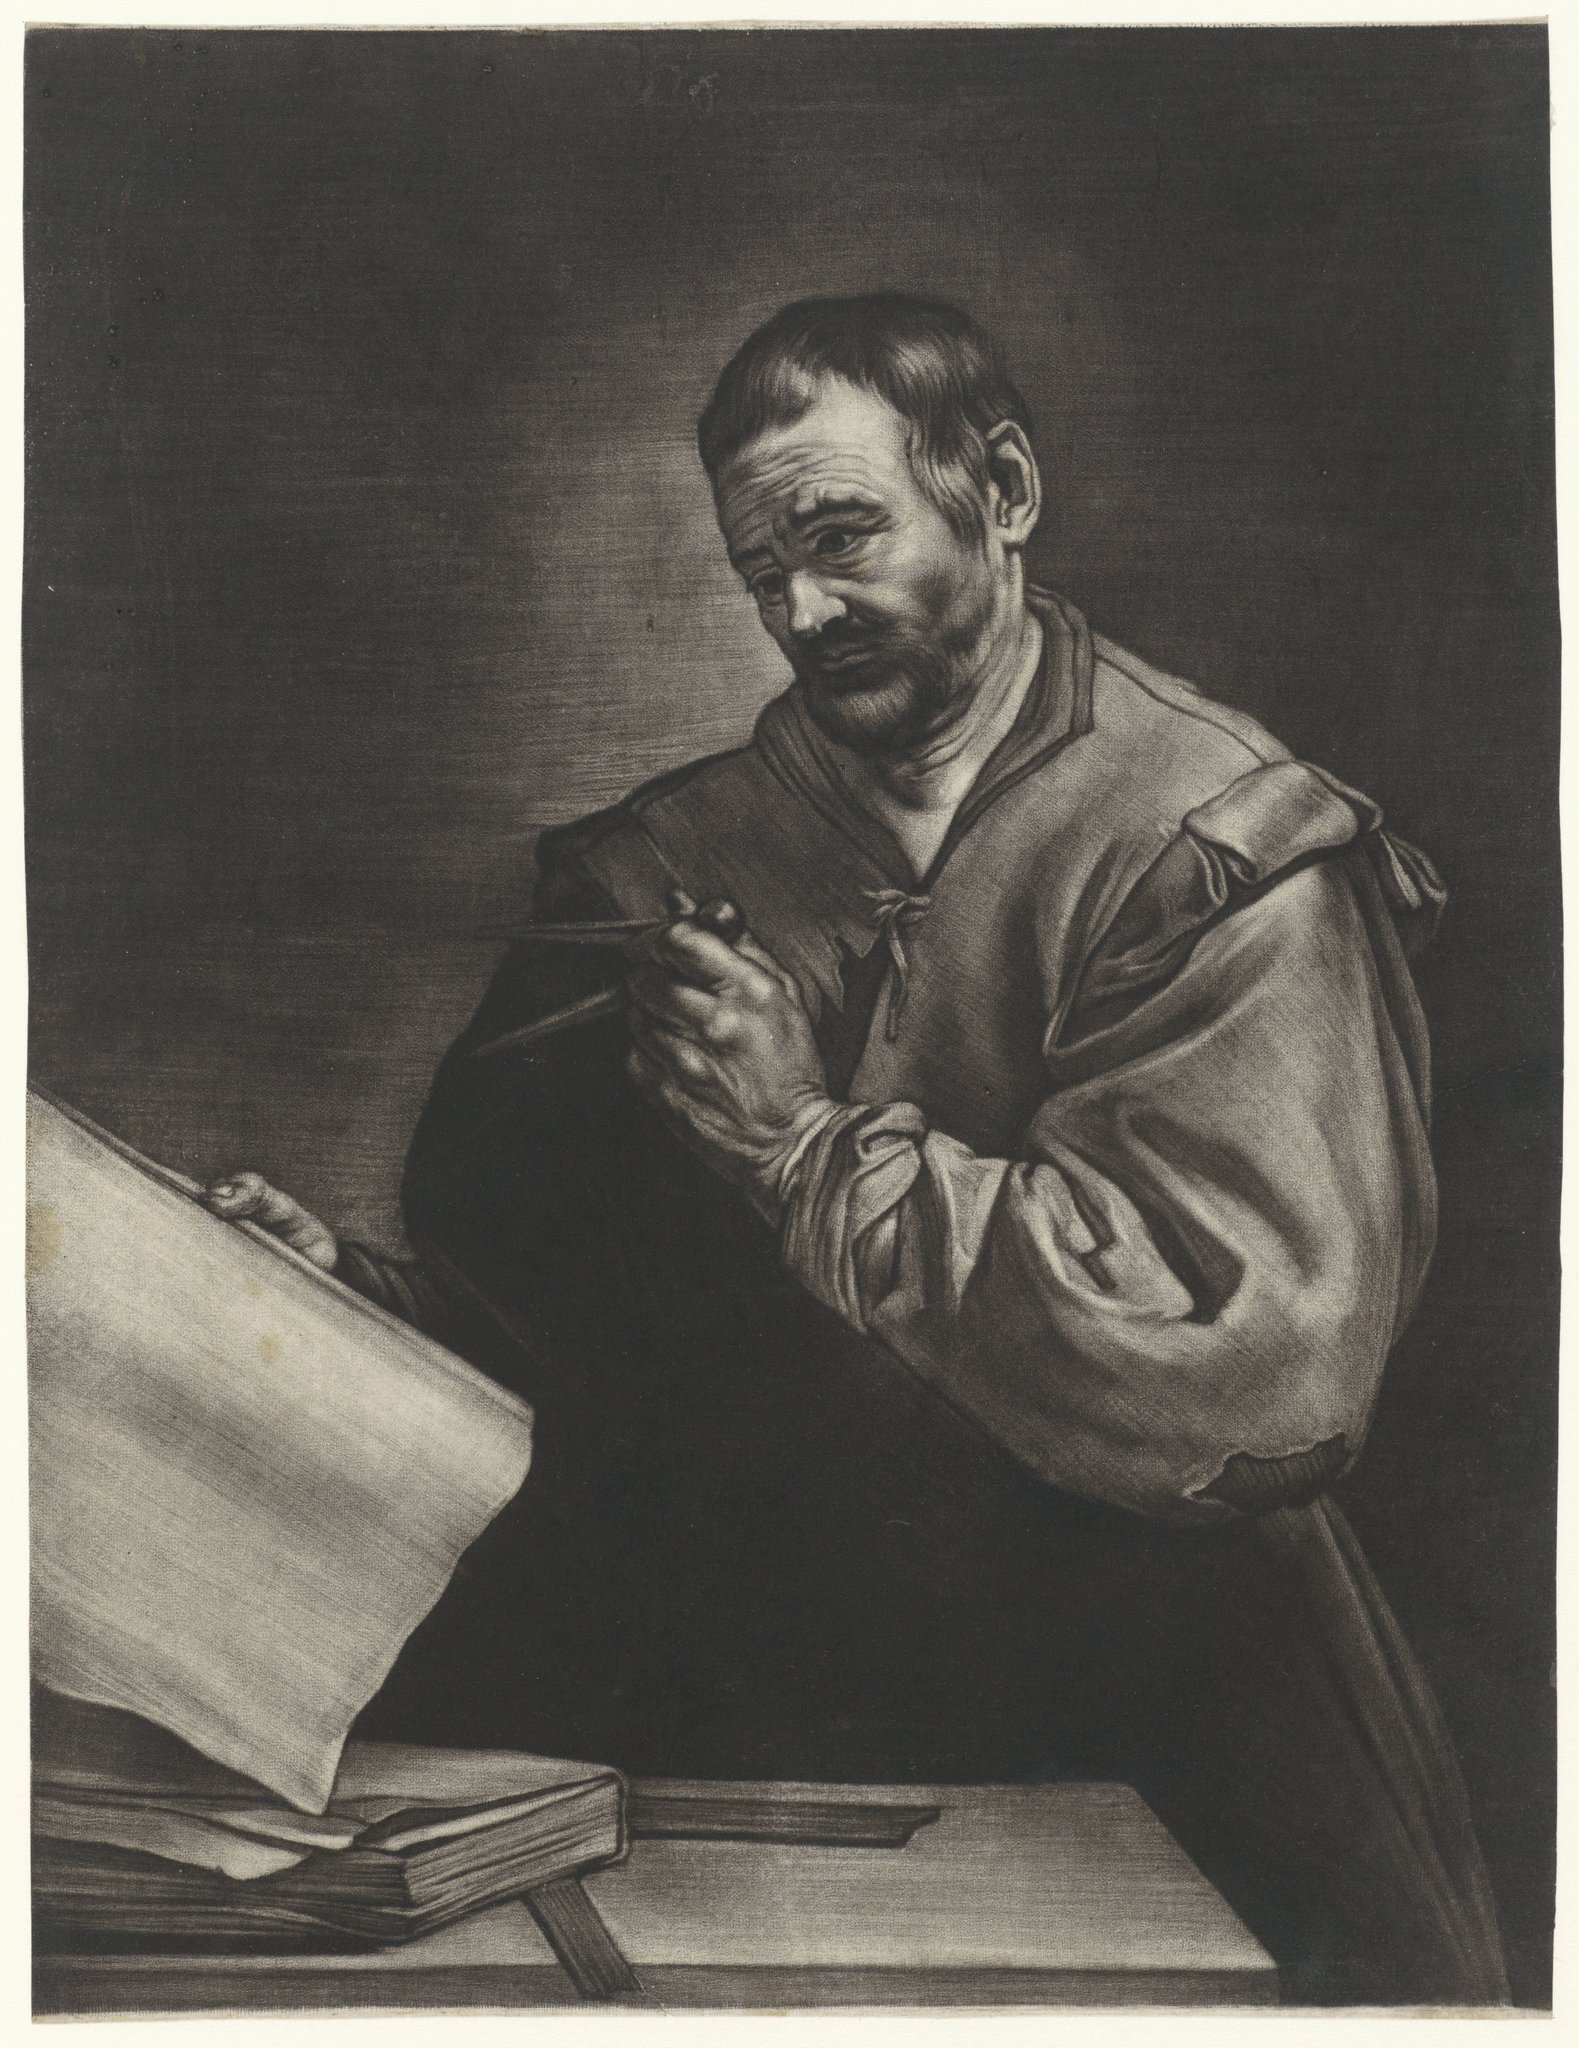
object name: print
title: Filosofen naar Spaanse voorbeelden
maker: bernard vaillant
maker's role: draughtsman, painter, print maker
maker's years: 1632-1698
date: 1672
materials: paper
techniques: mezzotint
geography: amsterdam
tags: scholar, philosopher, (story of) heraclitus, the philosopher, compasses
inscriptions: collector's mark: Lugt 2028